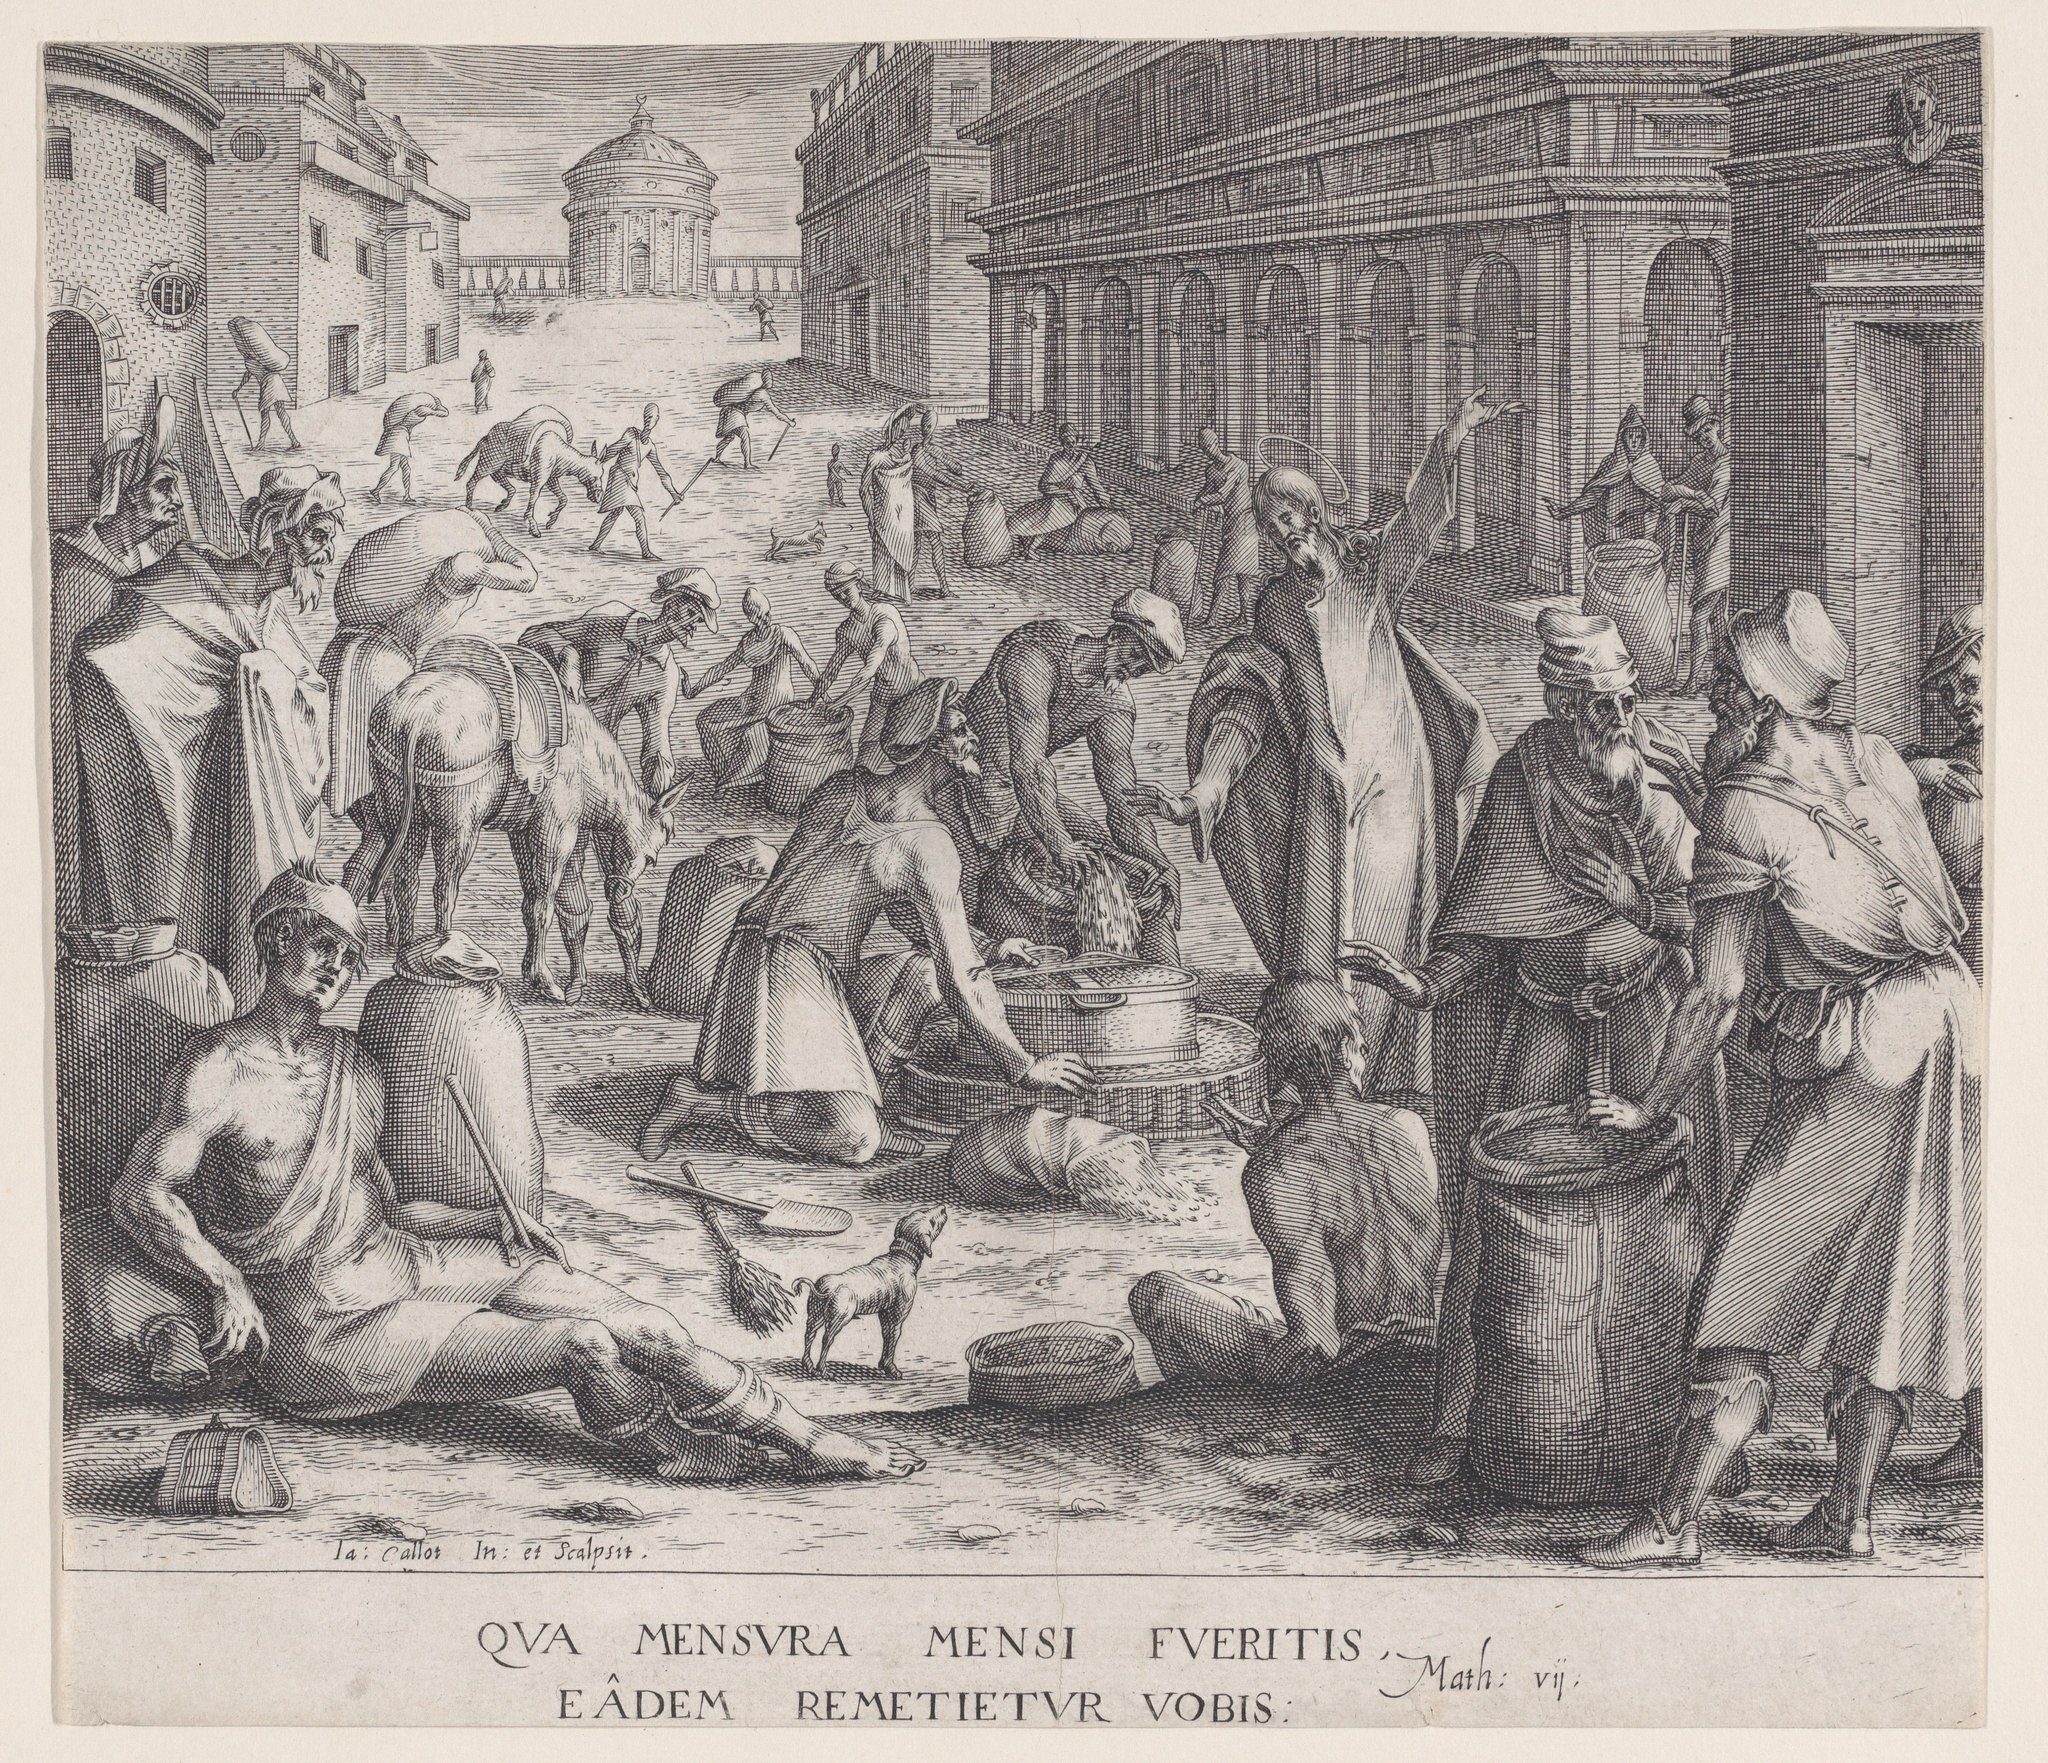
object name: print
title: Les Mesureurs de Grains (The Grain Measurers)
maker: jacques callot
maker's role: artist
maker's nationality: french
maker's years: 1592-1635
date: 1610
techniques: engraving